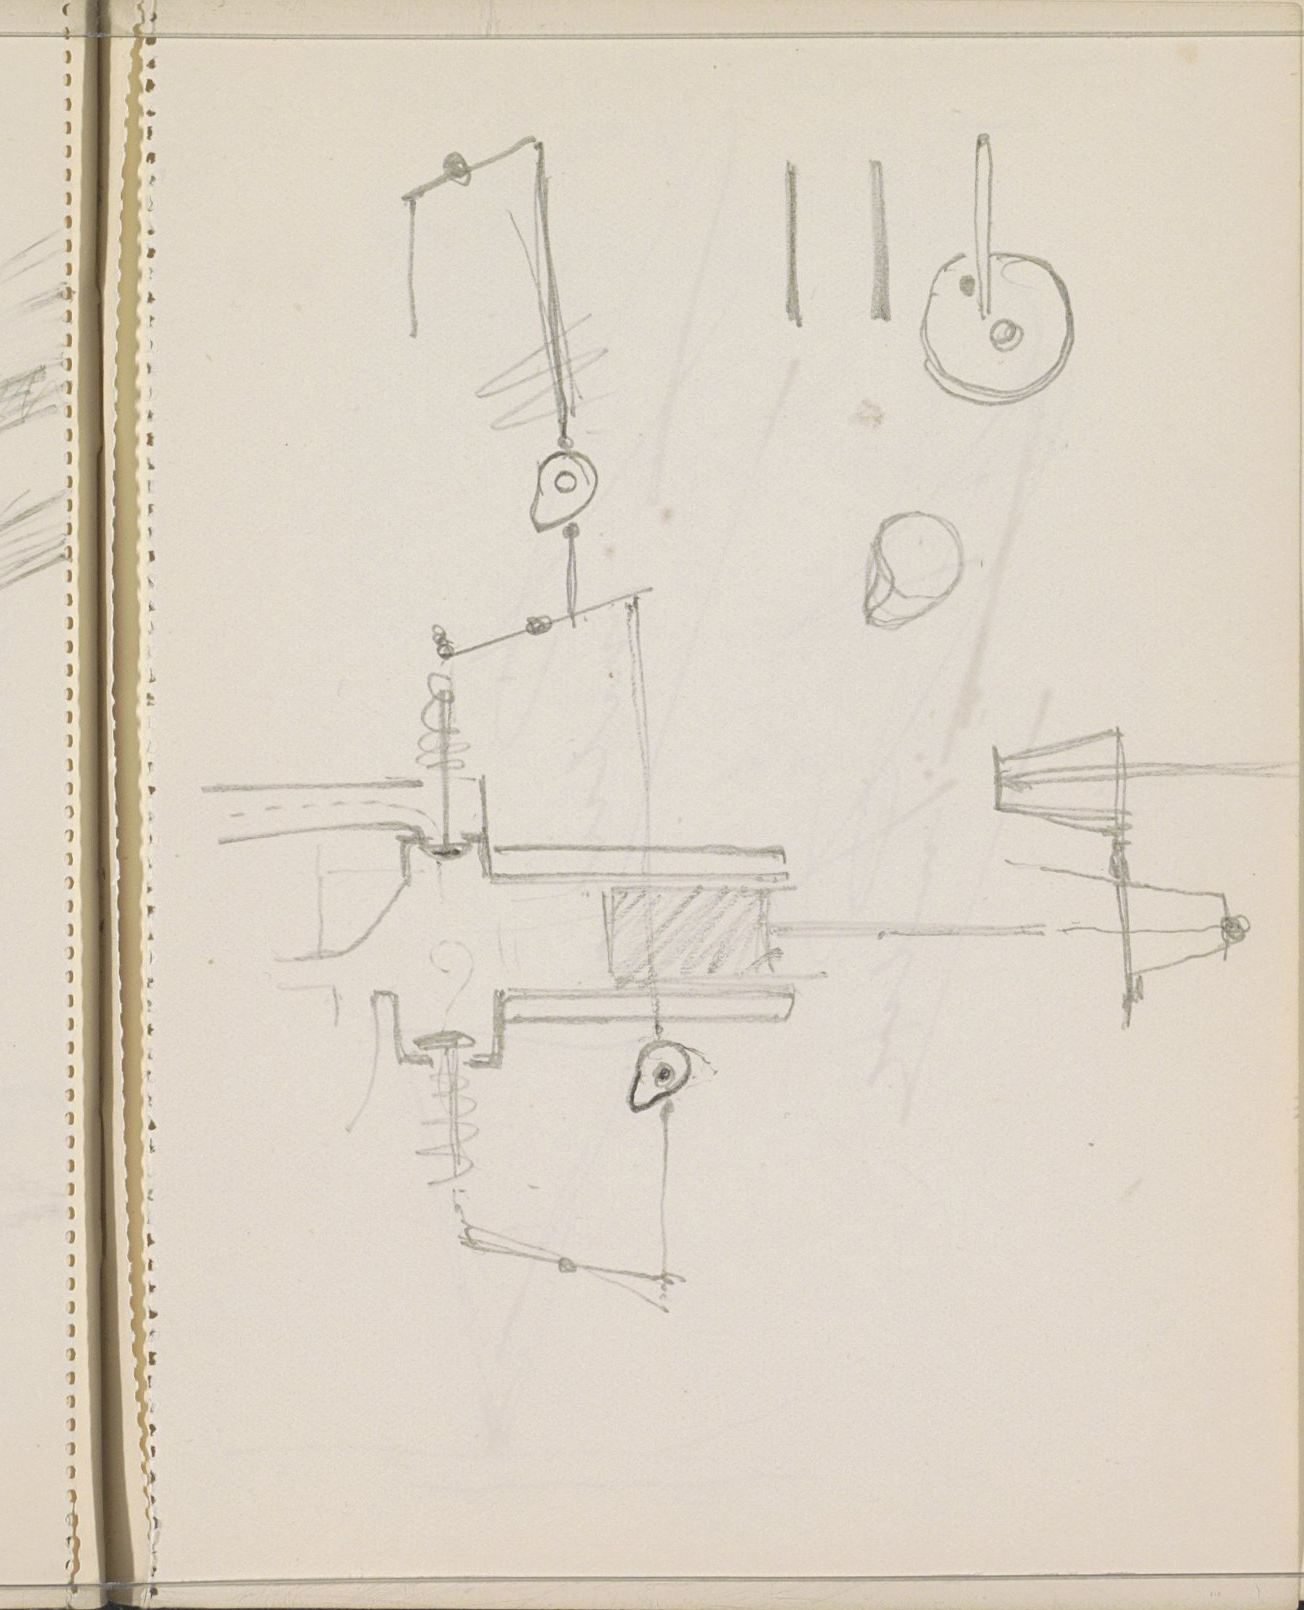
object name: sketchbook leaf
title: Vliegtuigonderdelen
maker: reijer stolk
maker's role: draughtsman, print maker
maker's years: 1896-1945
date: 1906-1945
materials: paper, pencil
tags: parts, attachments of aircraft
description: Onder andere wielen. Blad 19 recto uit een schetsboek met 42 bladen.